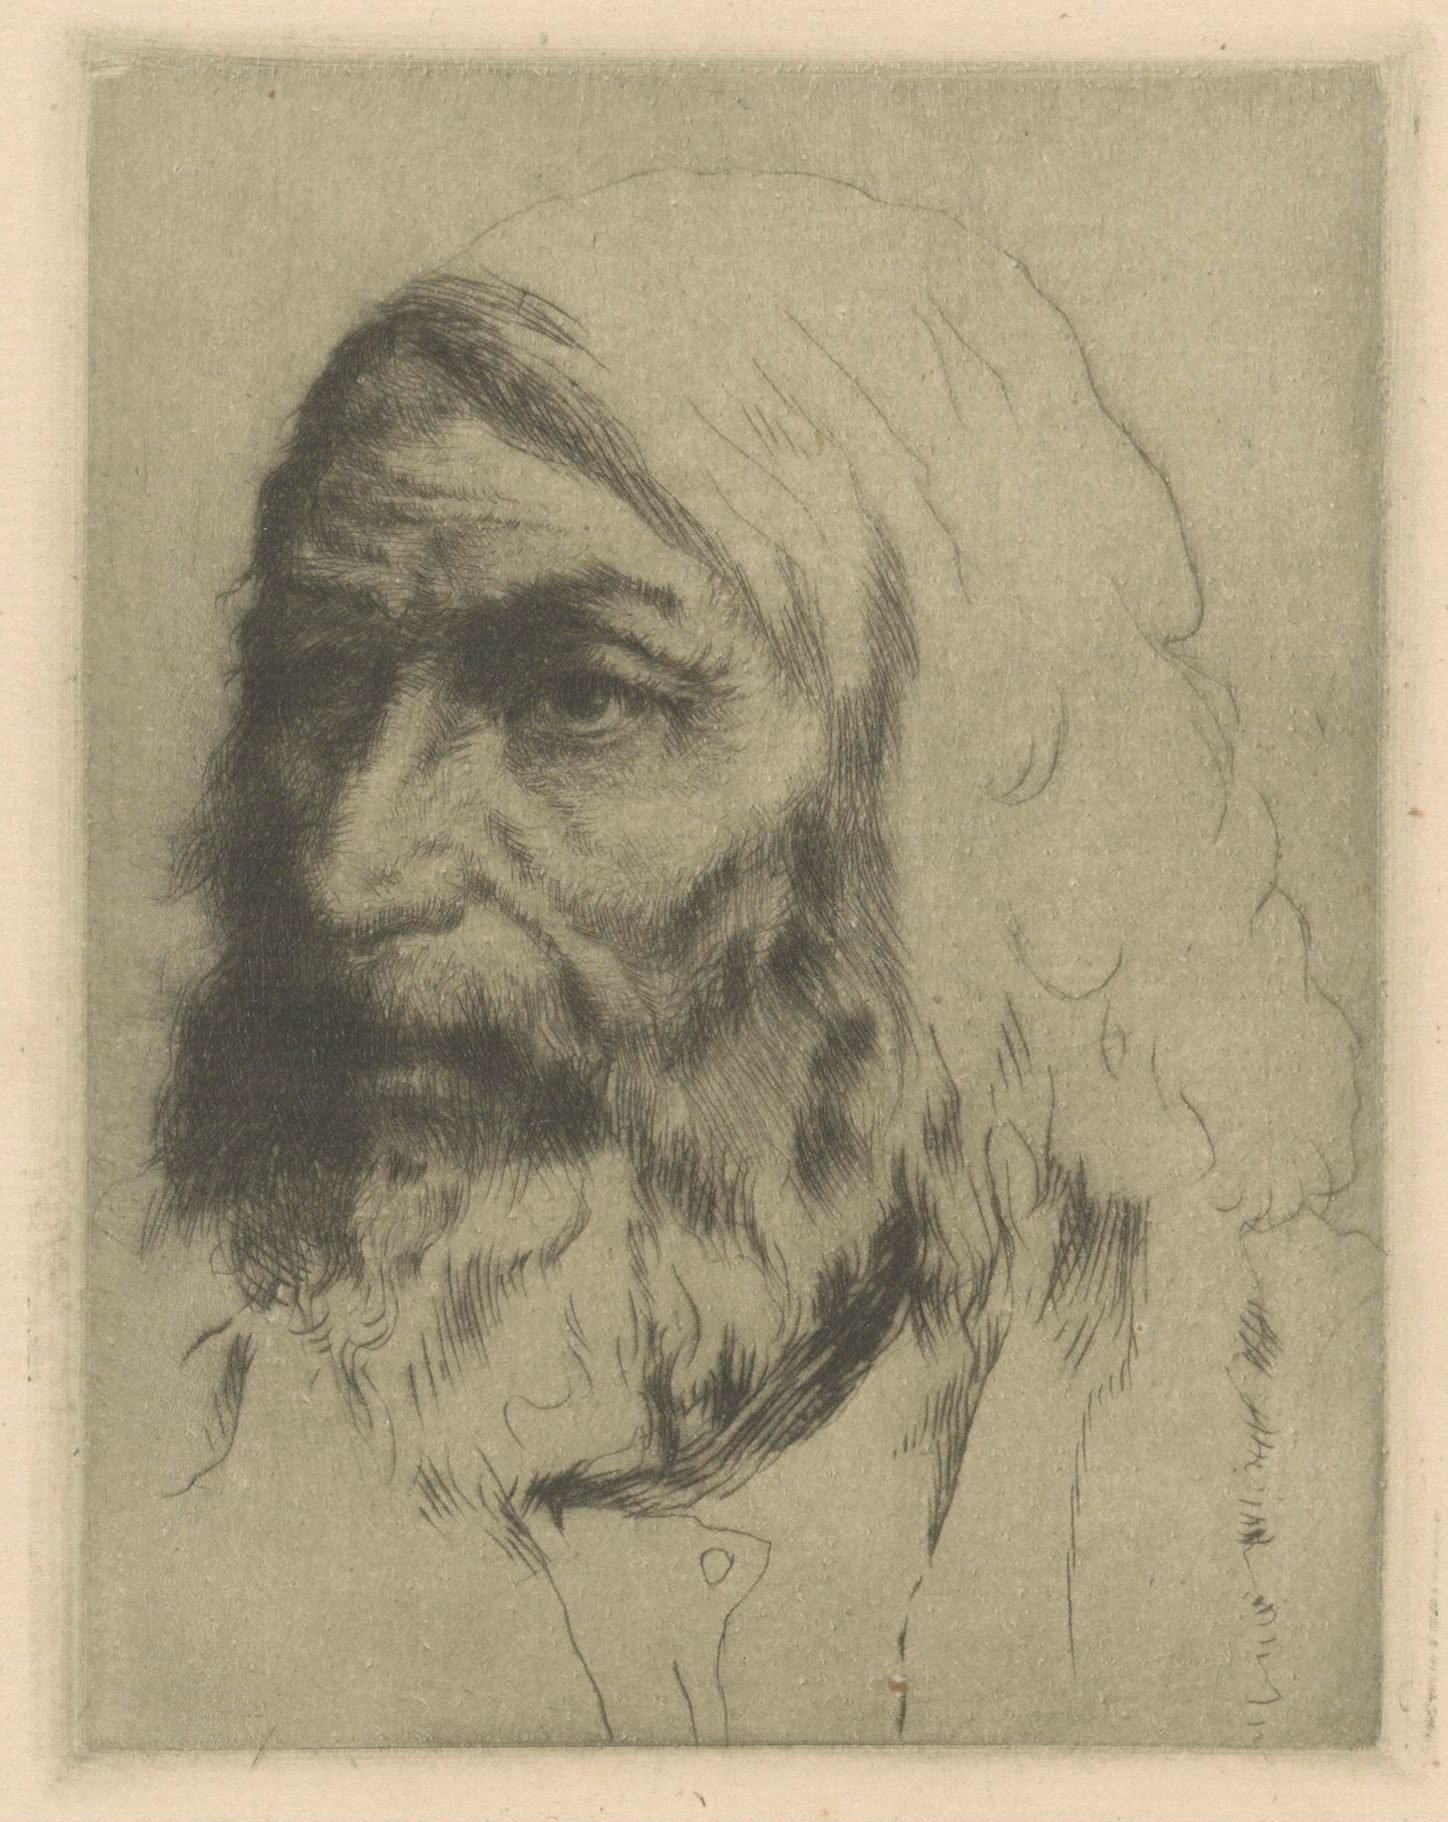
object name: print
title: Oude man met baard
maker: frans hermesdorf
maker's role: painter, print maker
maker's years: 1854-1904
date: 1864-1904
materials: paper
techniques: etching, intaglio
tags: old man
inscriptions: collector's mark: Lugt 2228